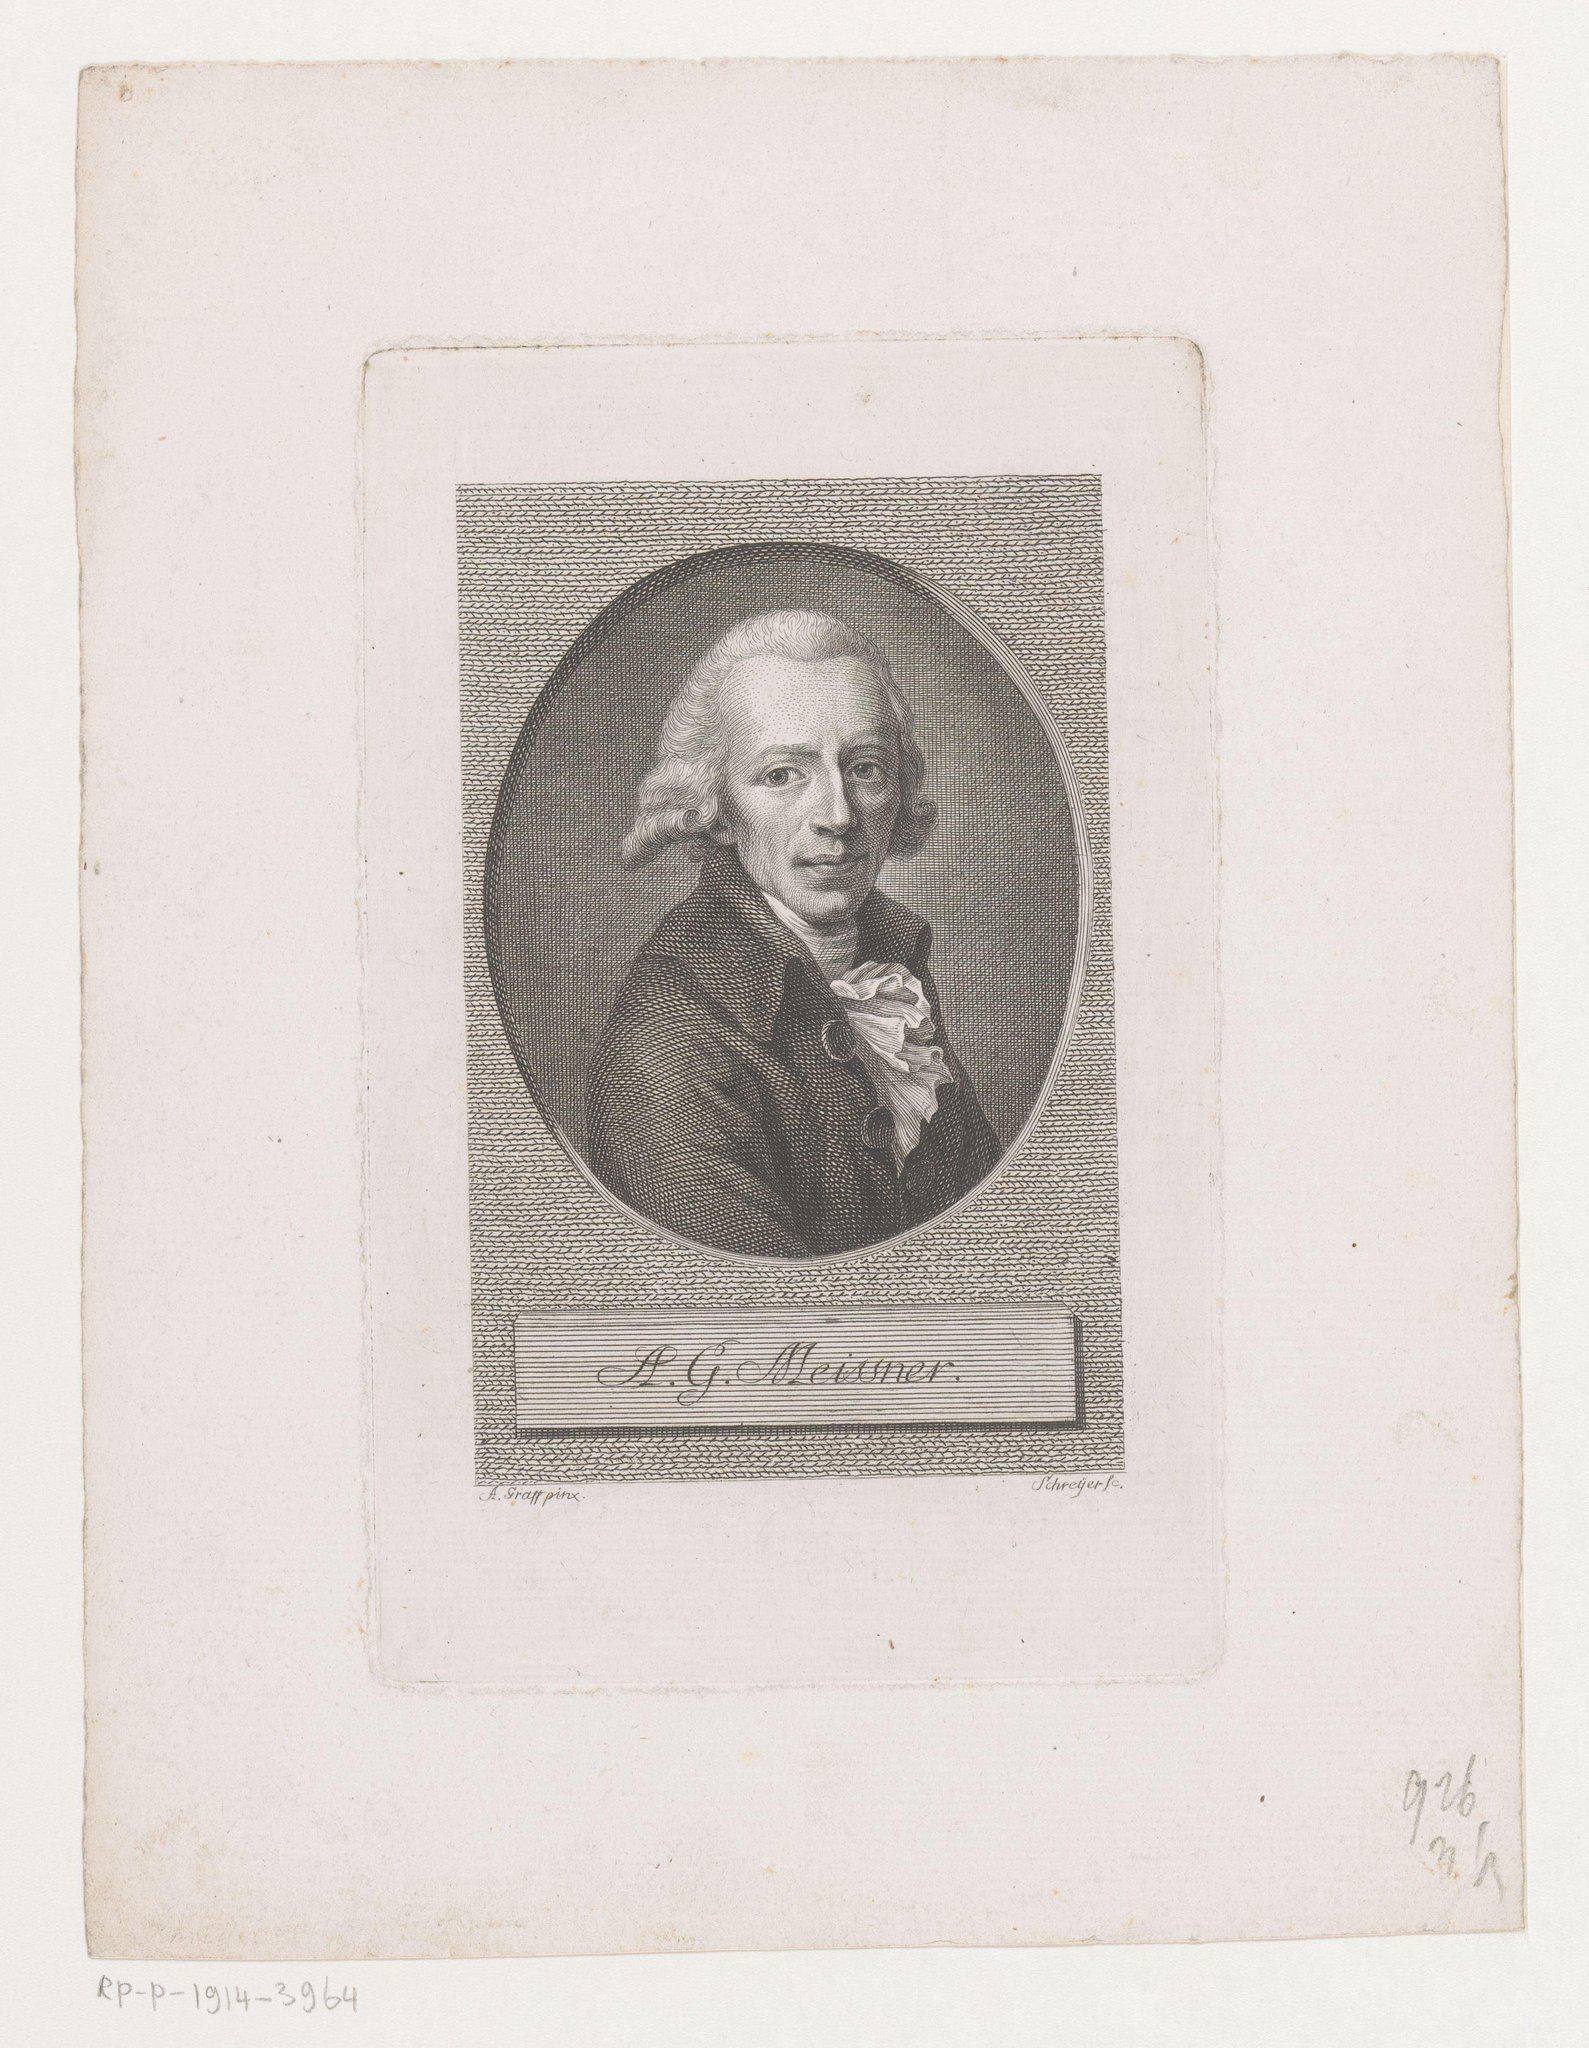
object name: print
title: Portret van August Gottlieb Meissner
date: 1778-1795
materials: paper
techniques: engraving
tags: further education (+ portrait of teacher, professor), historical persons, portrait of a writer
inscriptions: collector's mark: Lugt 2228